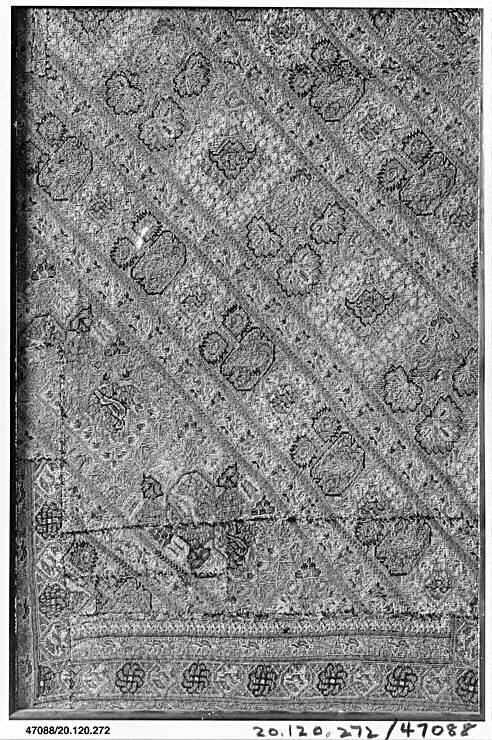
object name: panel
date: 1701-1800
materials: linen, silk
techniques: embroidery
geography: iran